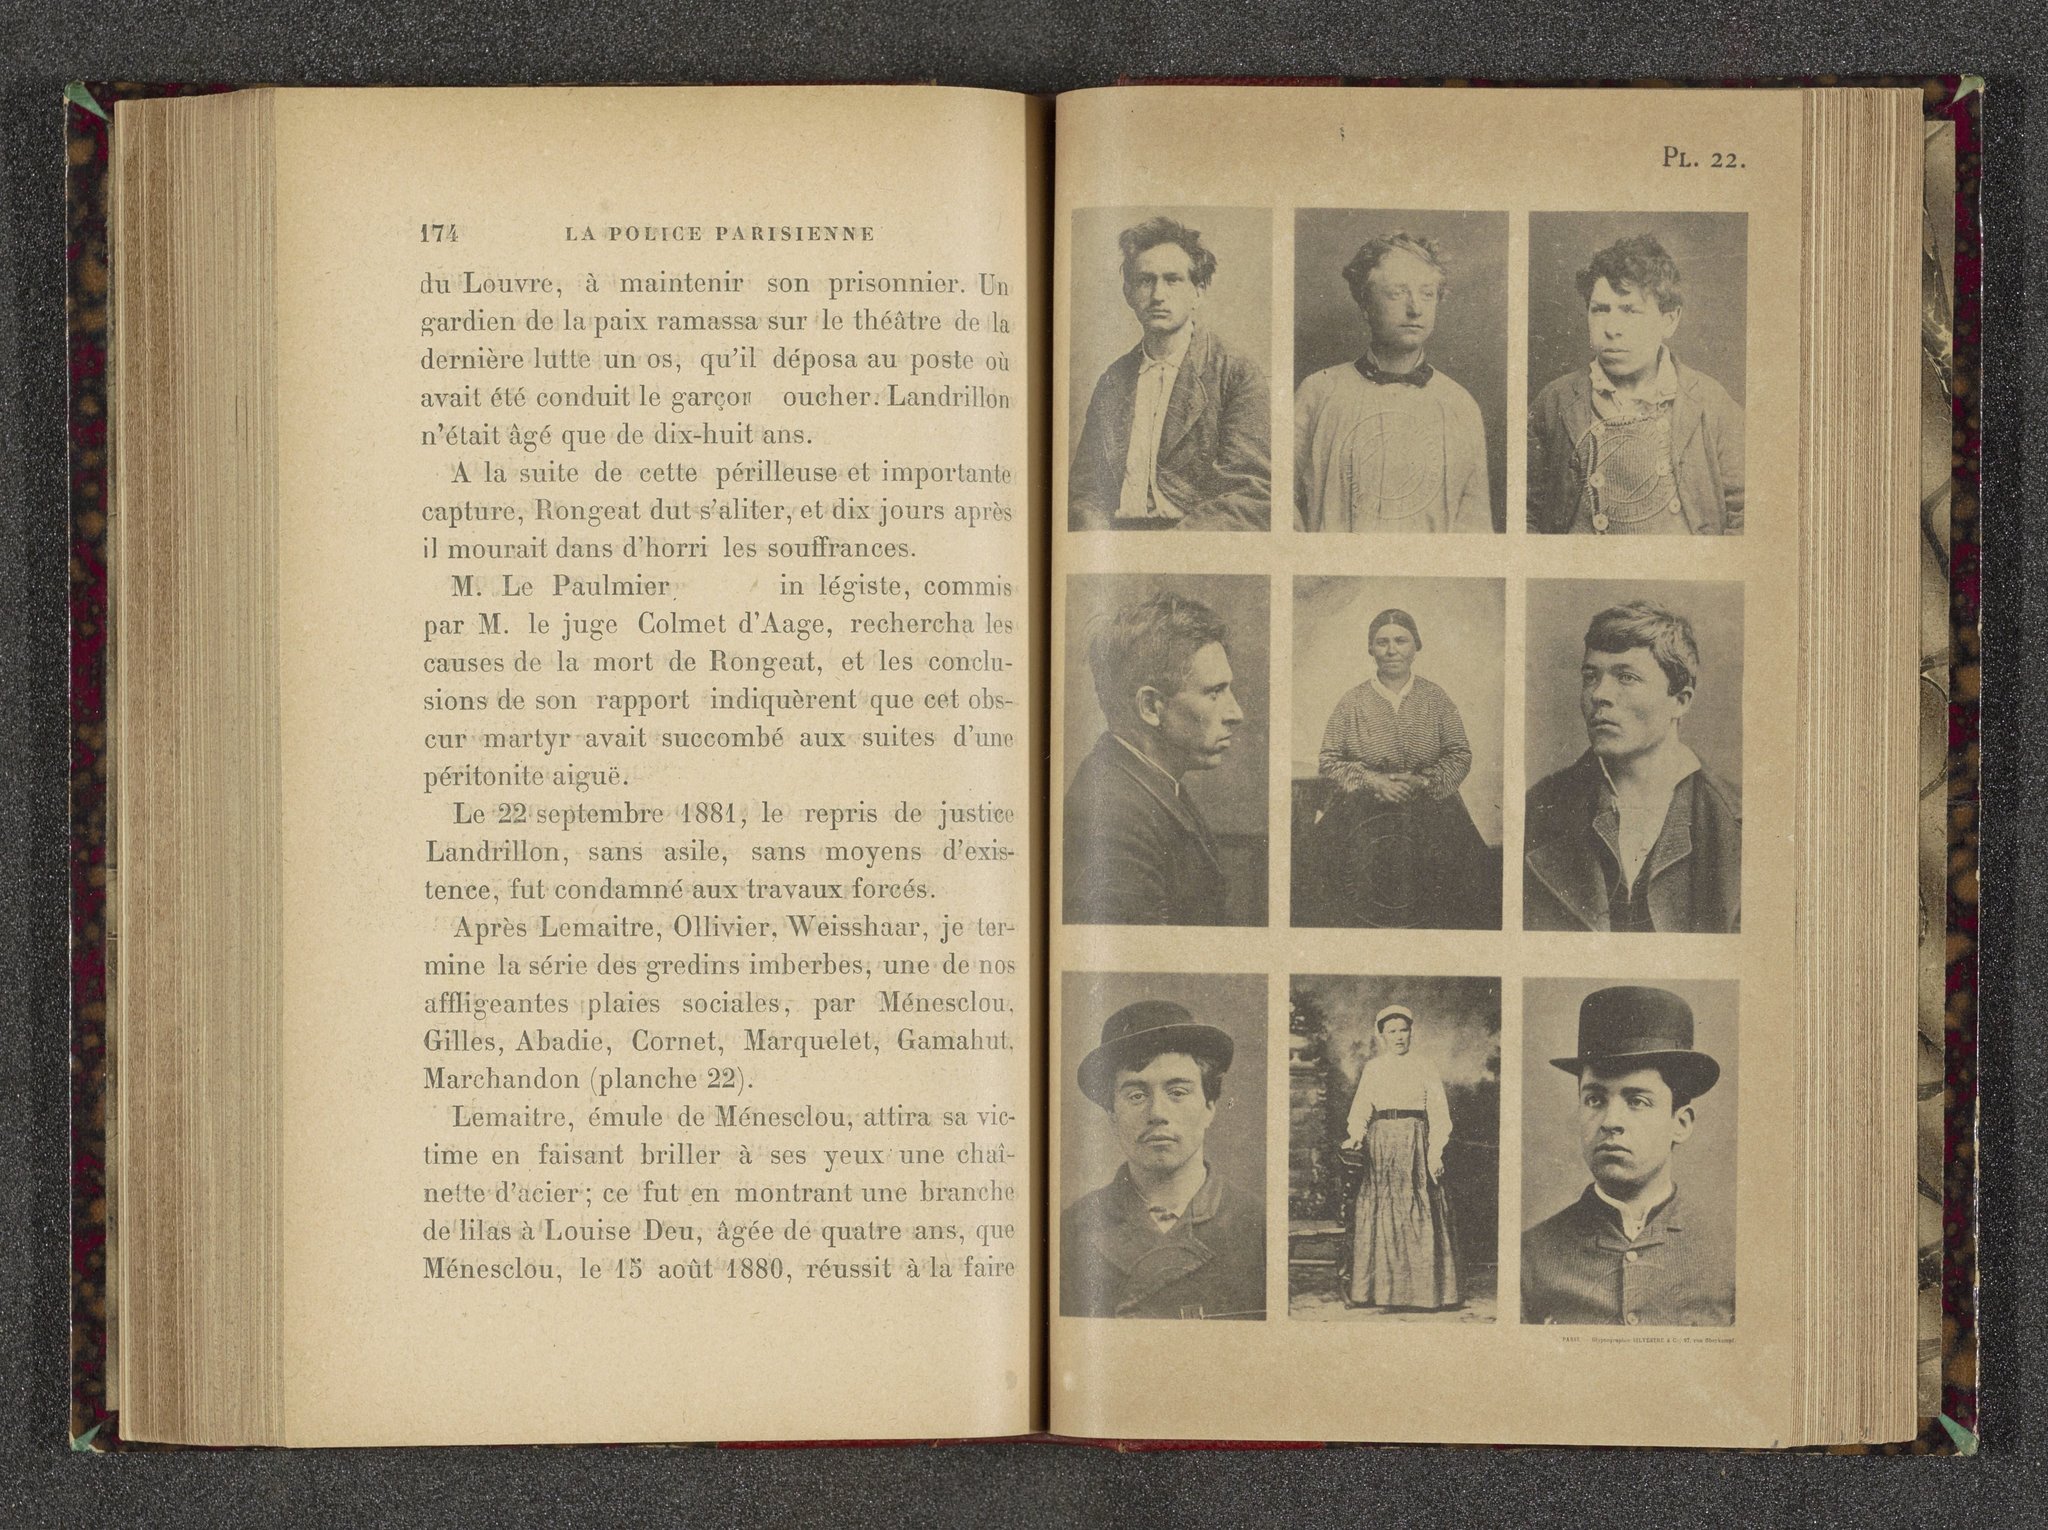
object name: page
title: Negen portretten van onbekende criminelen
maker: Anonymous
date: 1880-1890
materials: paper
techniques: photograph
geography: france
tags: criminals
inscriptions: number: ‘Pl. 22.’